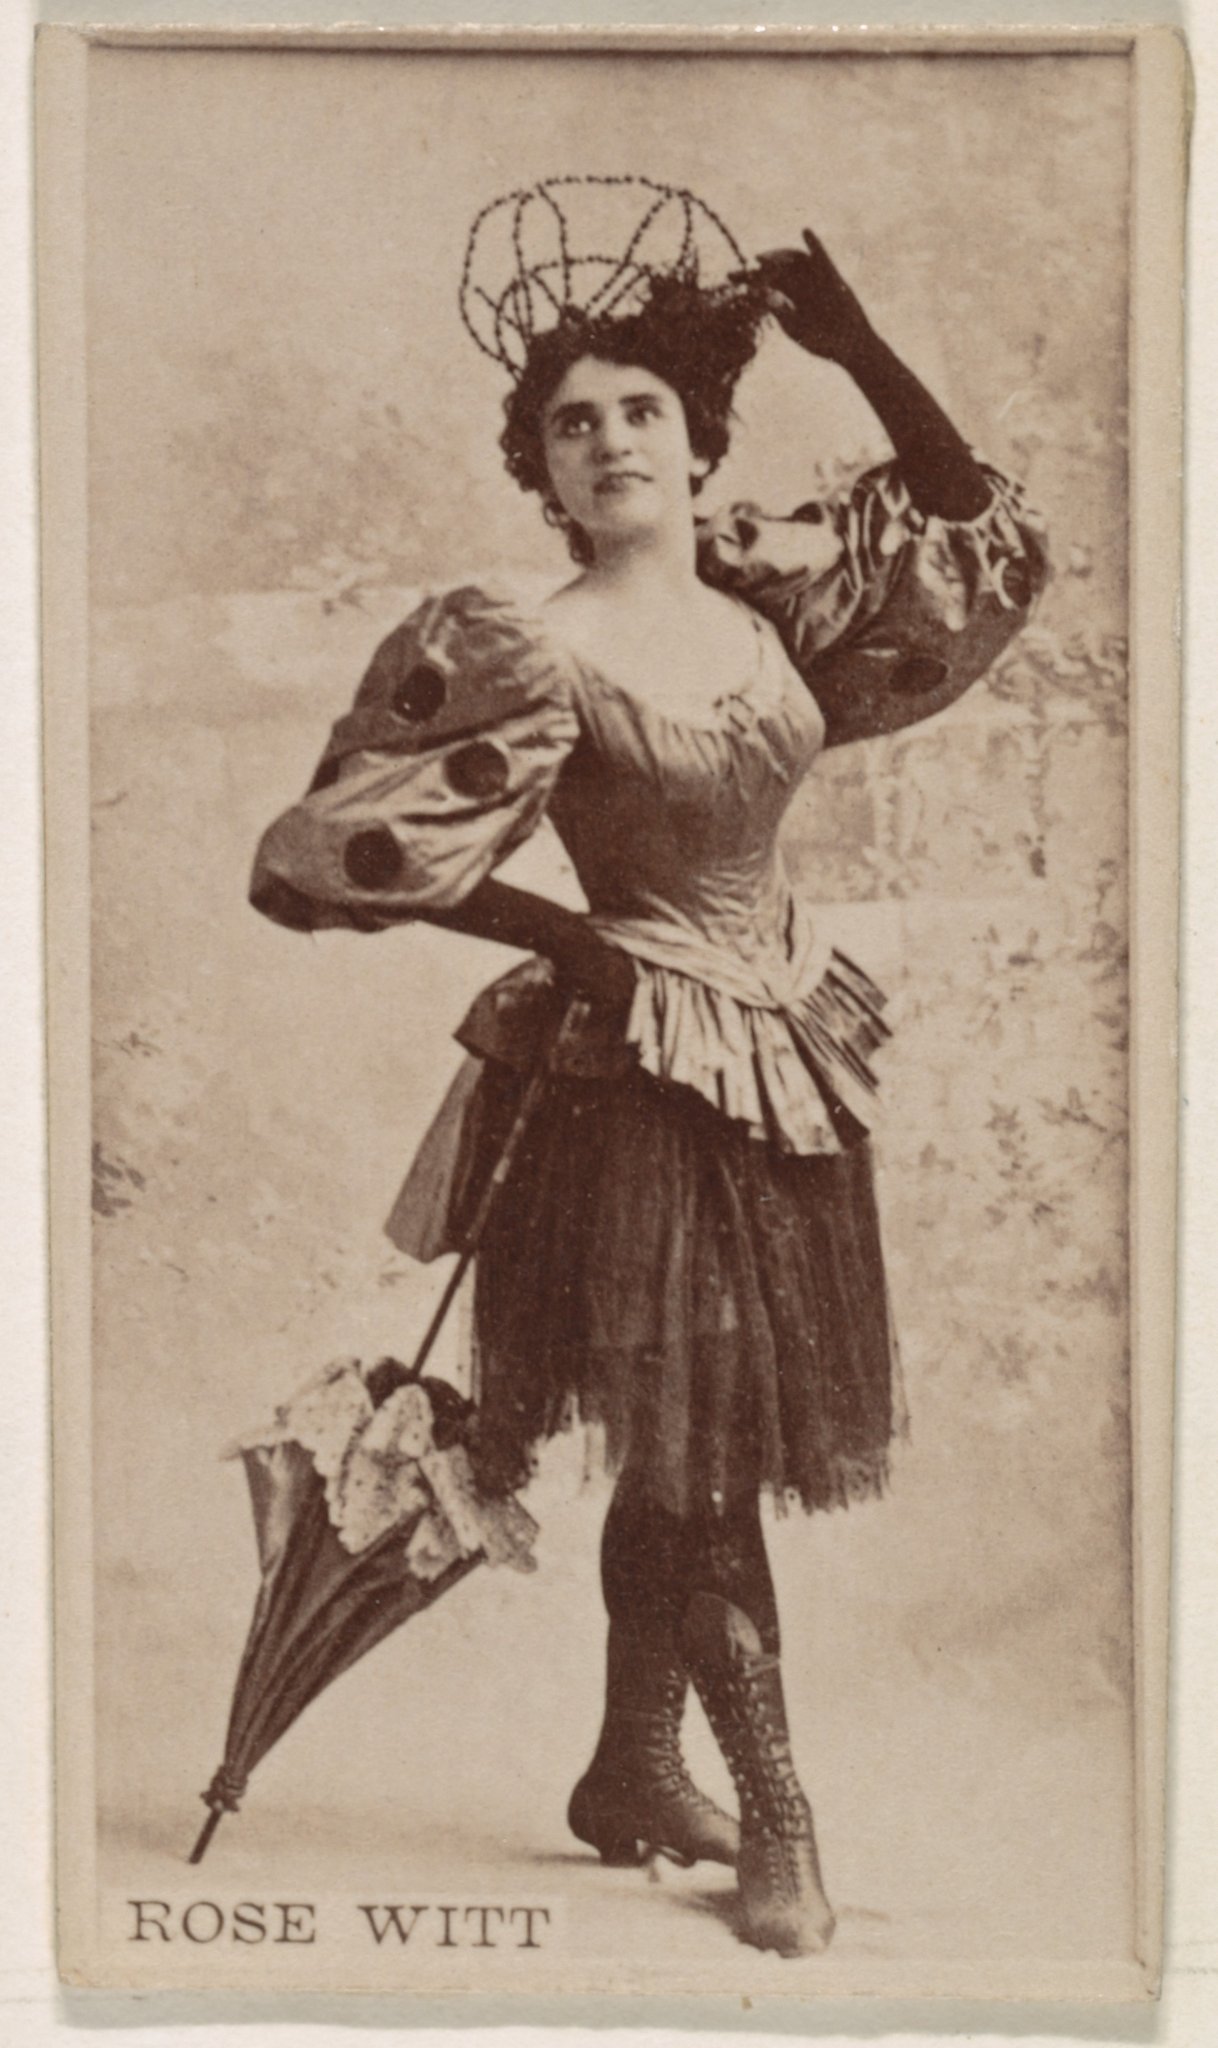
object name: photograph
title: Rose Witt, from the Actresses series (N245) issued by Kinney Brothers to promote Sweet Caporal Cigarettes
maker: kinney brothers tobacco company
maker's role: publisher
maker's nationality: american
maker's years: 1869-2011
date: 1890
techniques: albumen silver print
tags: portraits,women,actresses